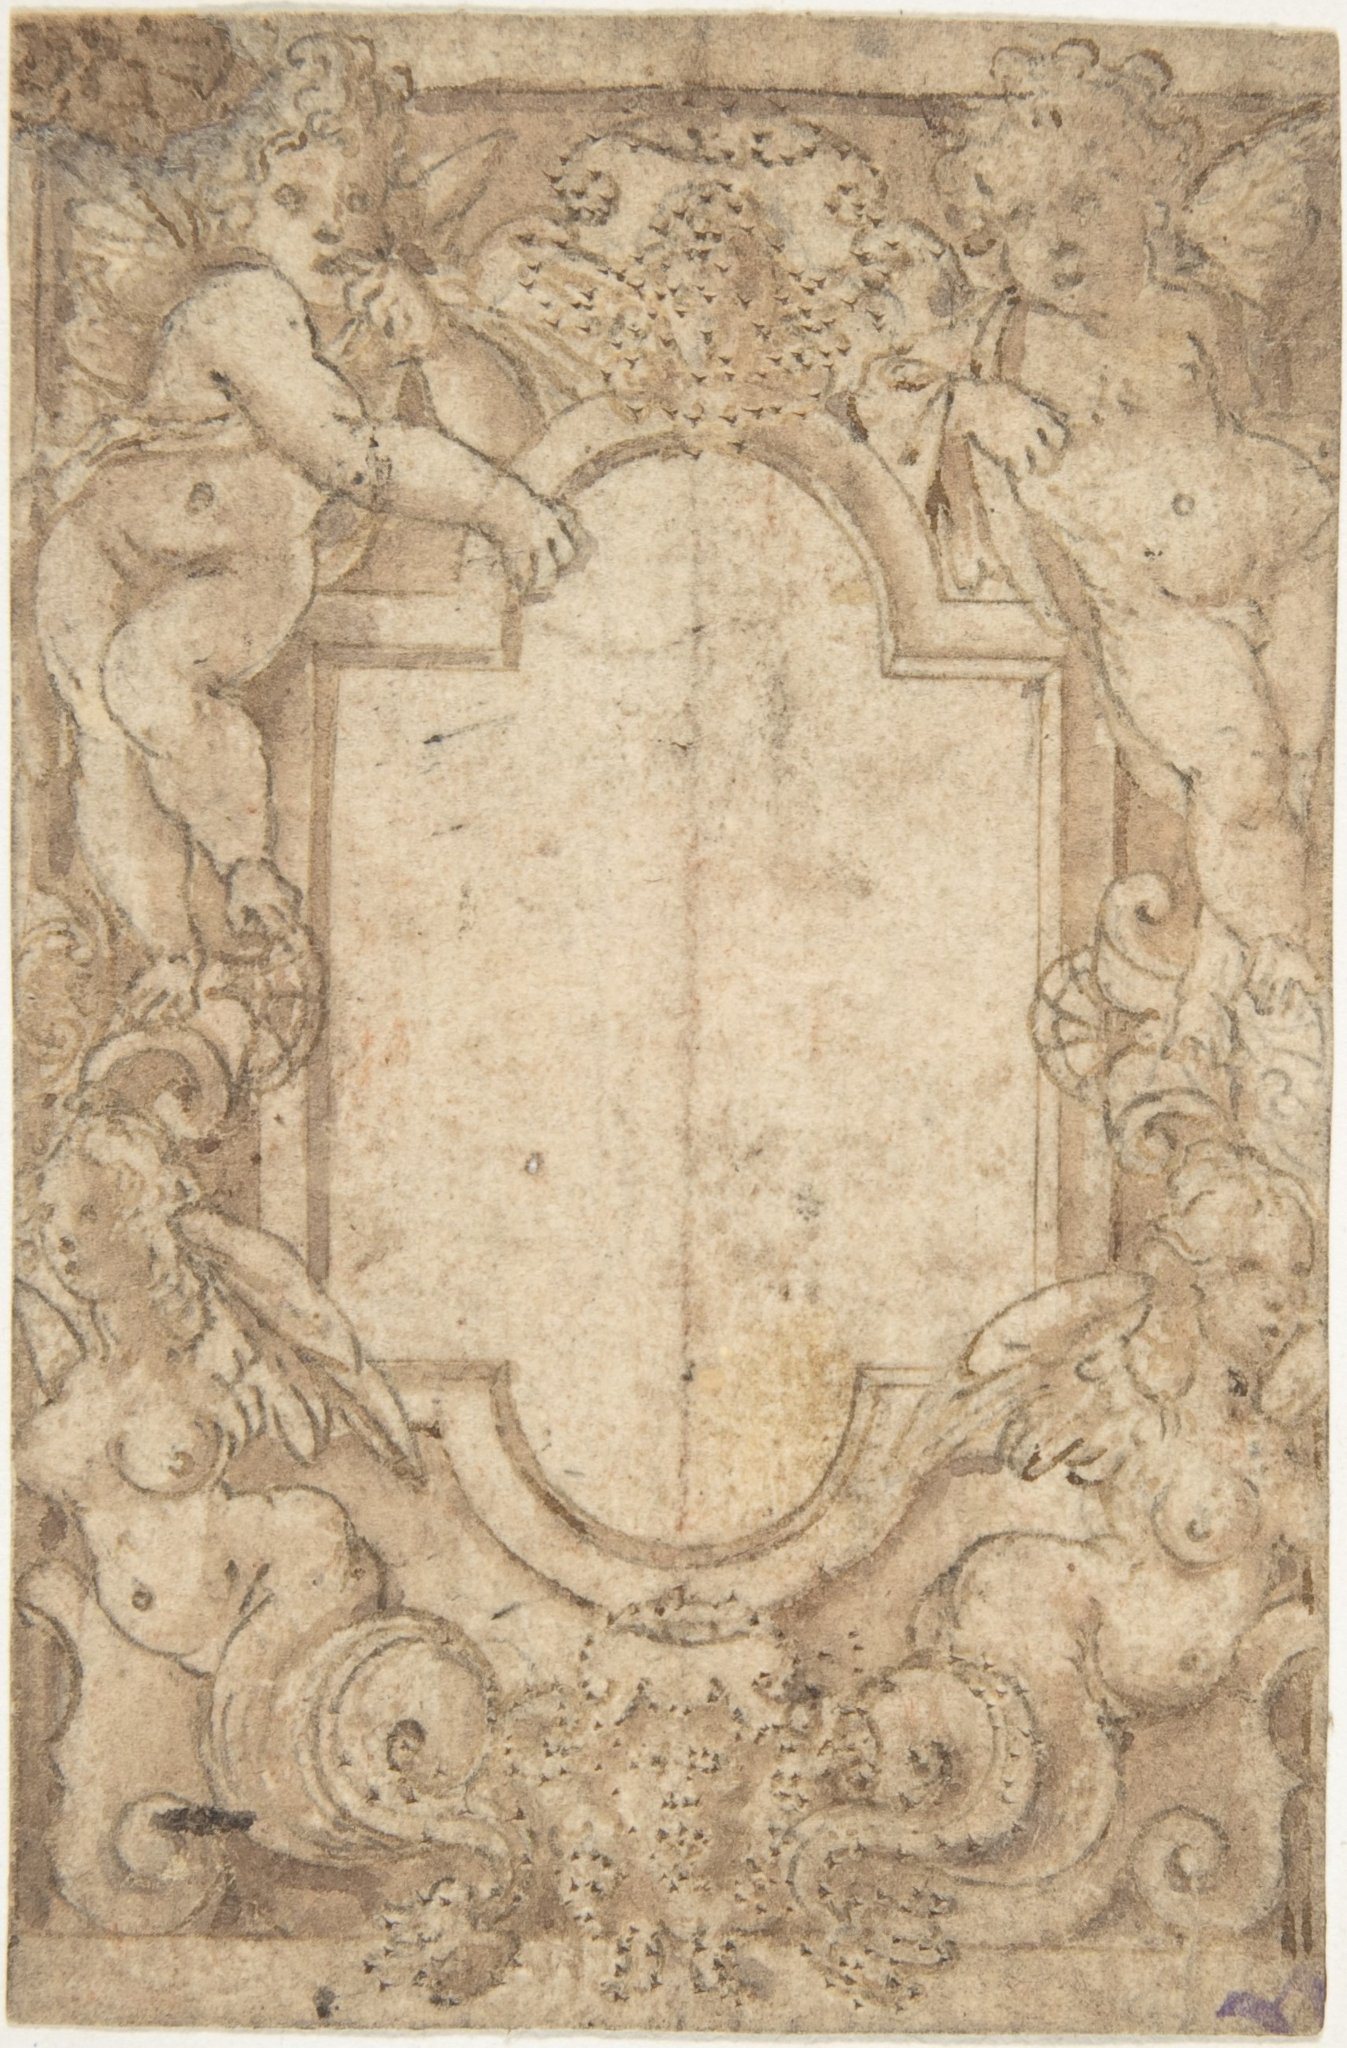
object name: drawing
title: Design for a Frame with Putti and Sirens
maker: anonymous, italian, second half of the 16th century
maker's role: artist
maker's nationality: italian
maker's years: 1550-1600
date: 1550-1600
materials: chalk, ink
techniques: brush, pen, transfer, wash